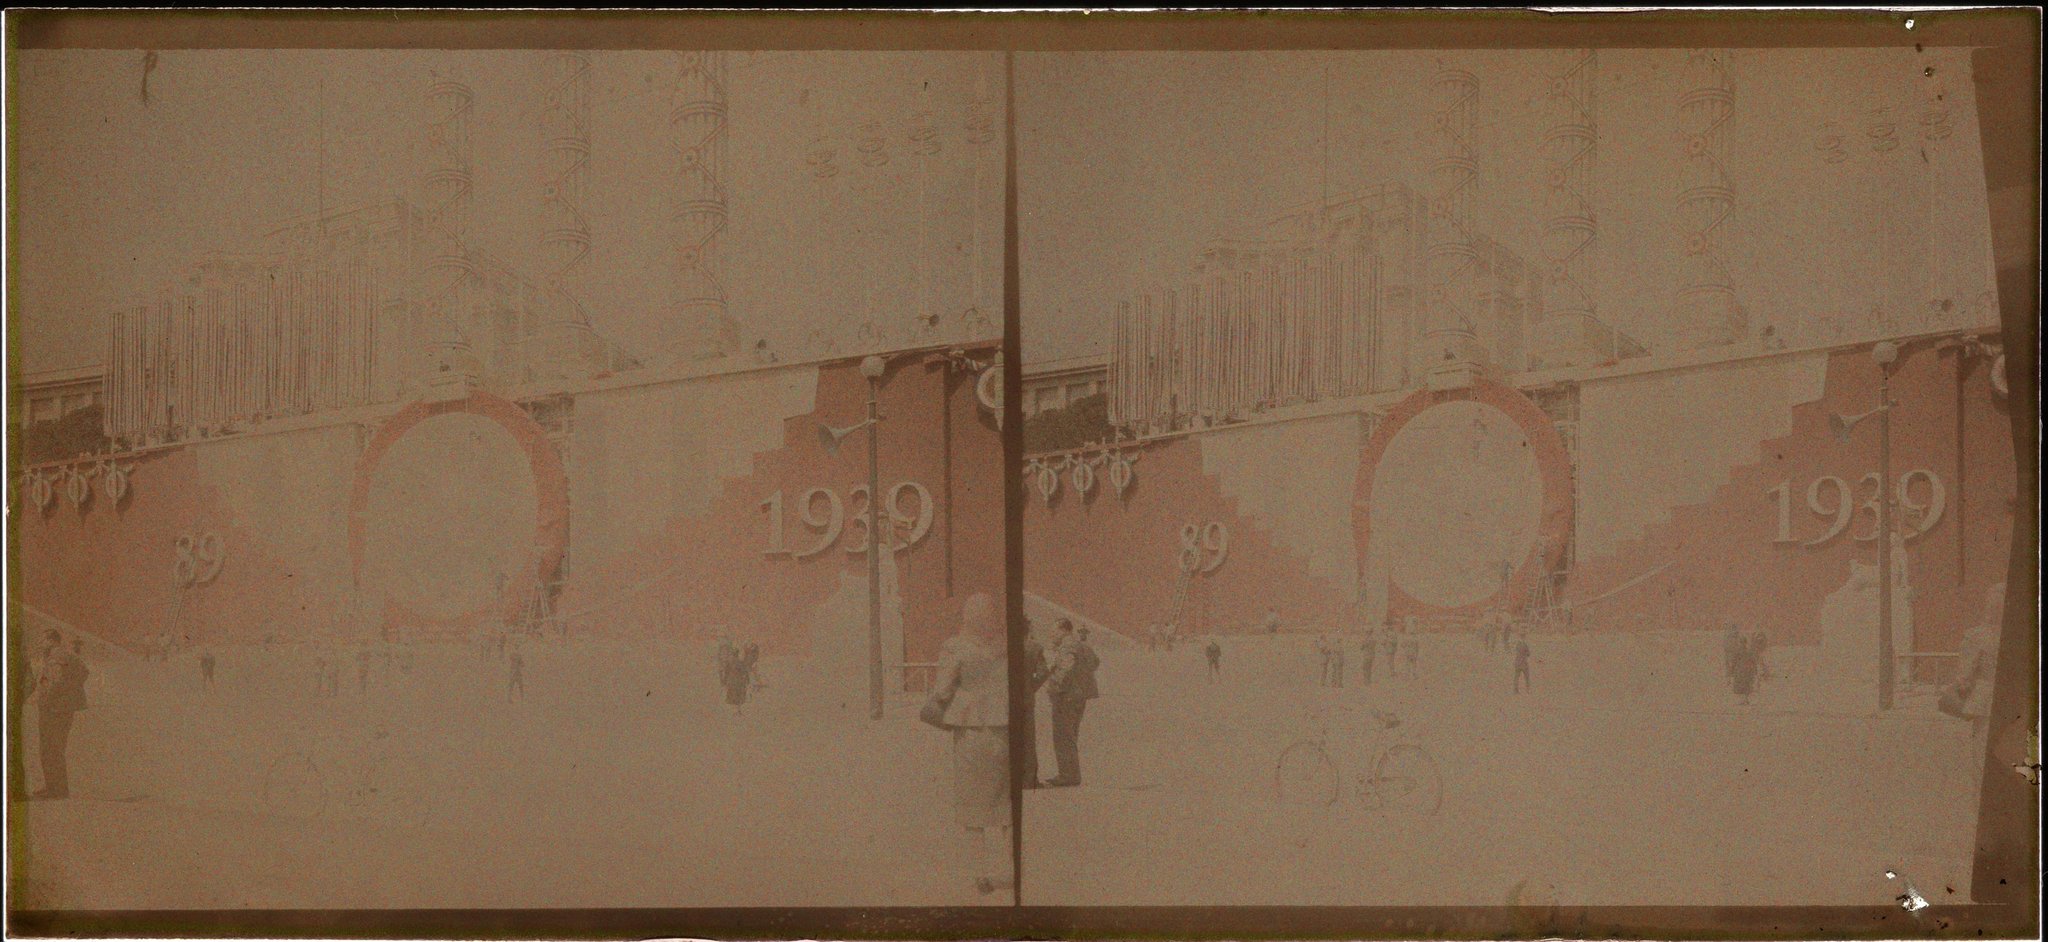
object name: stereograph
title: Trocadero Parijs, 1939 (vervaagd)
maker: Anonymous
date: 1939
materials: plastic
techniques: autochrome process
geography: paris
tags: paris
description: Mogelijk ter gelegenheid van de viering van 150 Franse Revolutie 1789-1939.